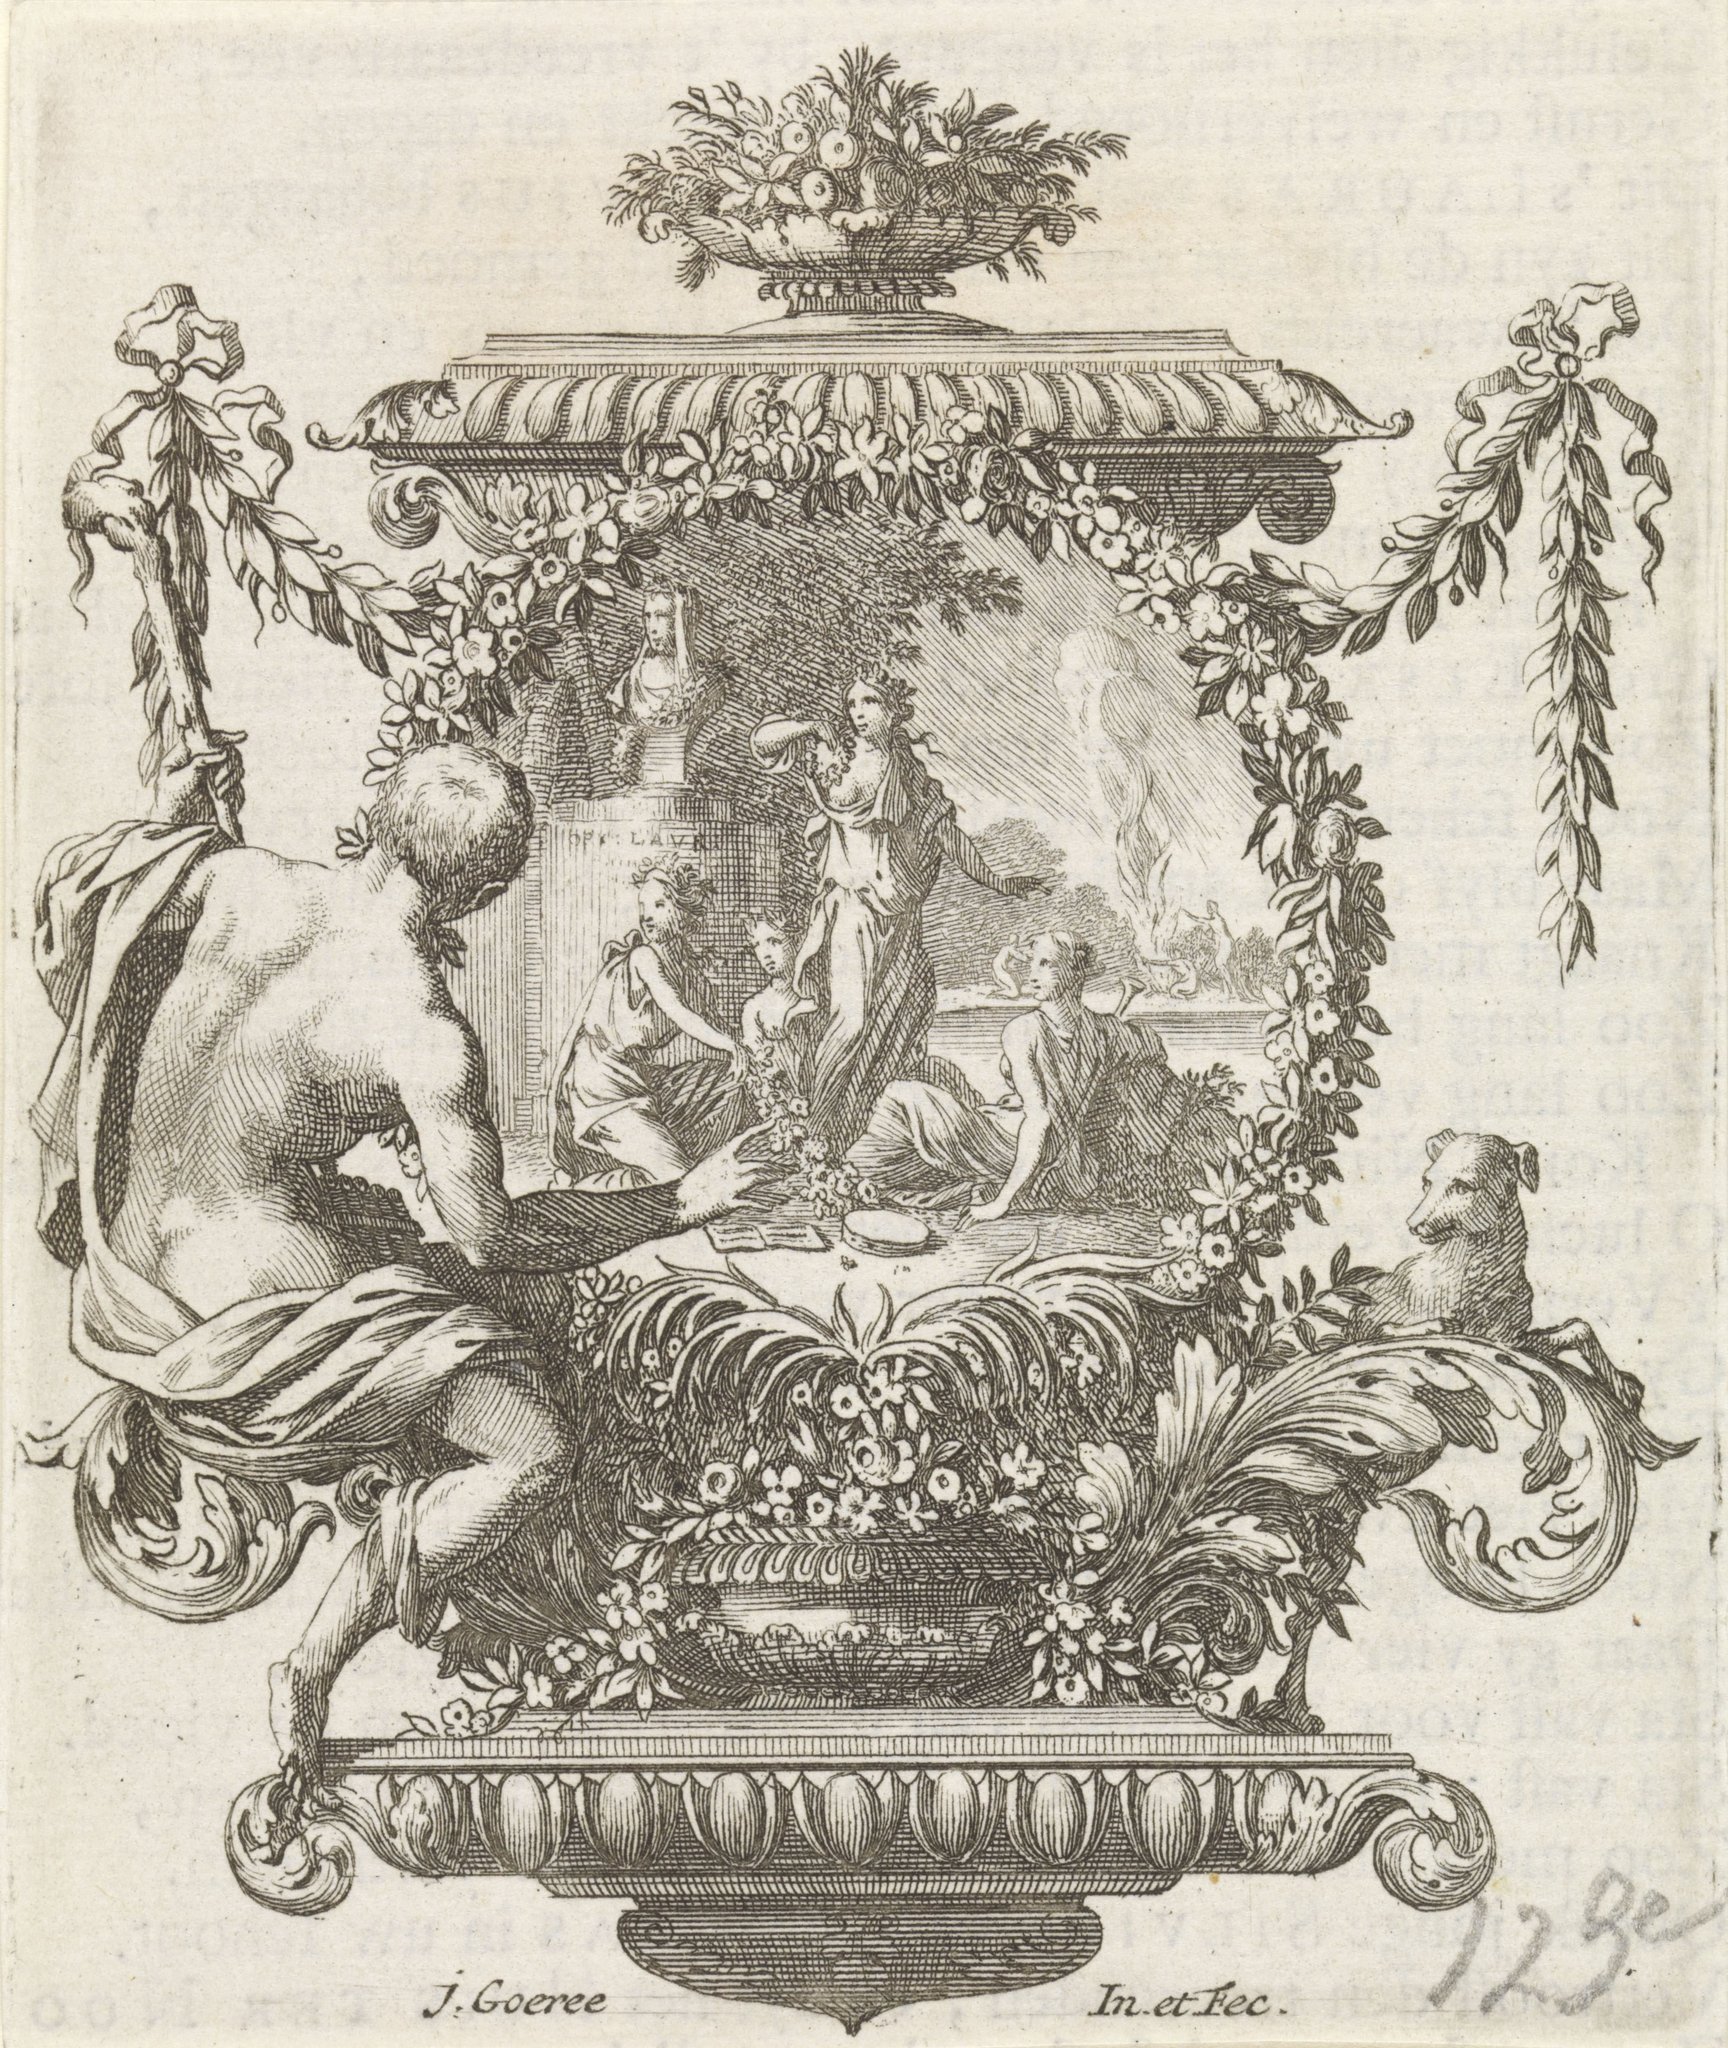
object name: print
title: Nimfen aan de oever van een rivier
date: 1710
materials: paper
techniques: engraving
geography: amsterdam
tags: fantasy ornament, monument, statue, naiads, river- and spring-nymphs; usually carrying an urn; 'naiadi, ninfe de' fiumi' (ripa)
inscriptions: collector's mark: Lugt 2228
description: Boekillustratie voor Jan Baptista Wellekens and Pieter Vlaming, "Dichtlievende Uitspanningen". Amsterdam bij A. van Damme, 1710, p. 4.